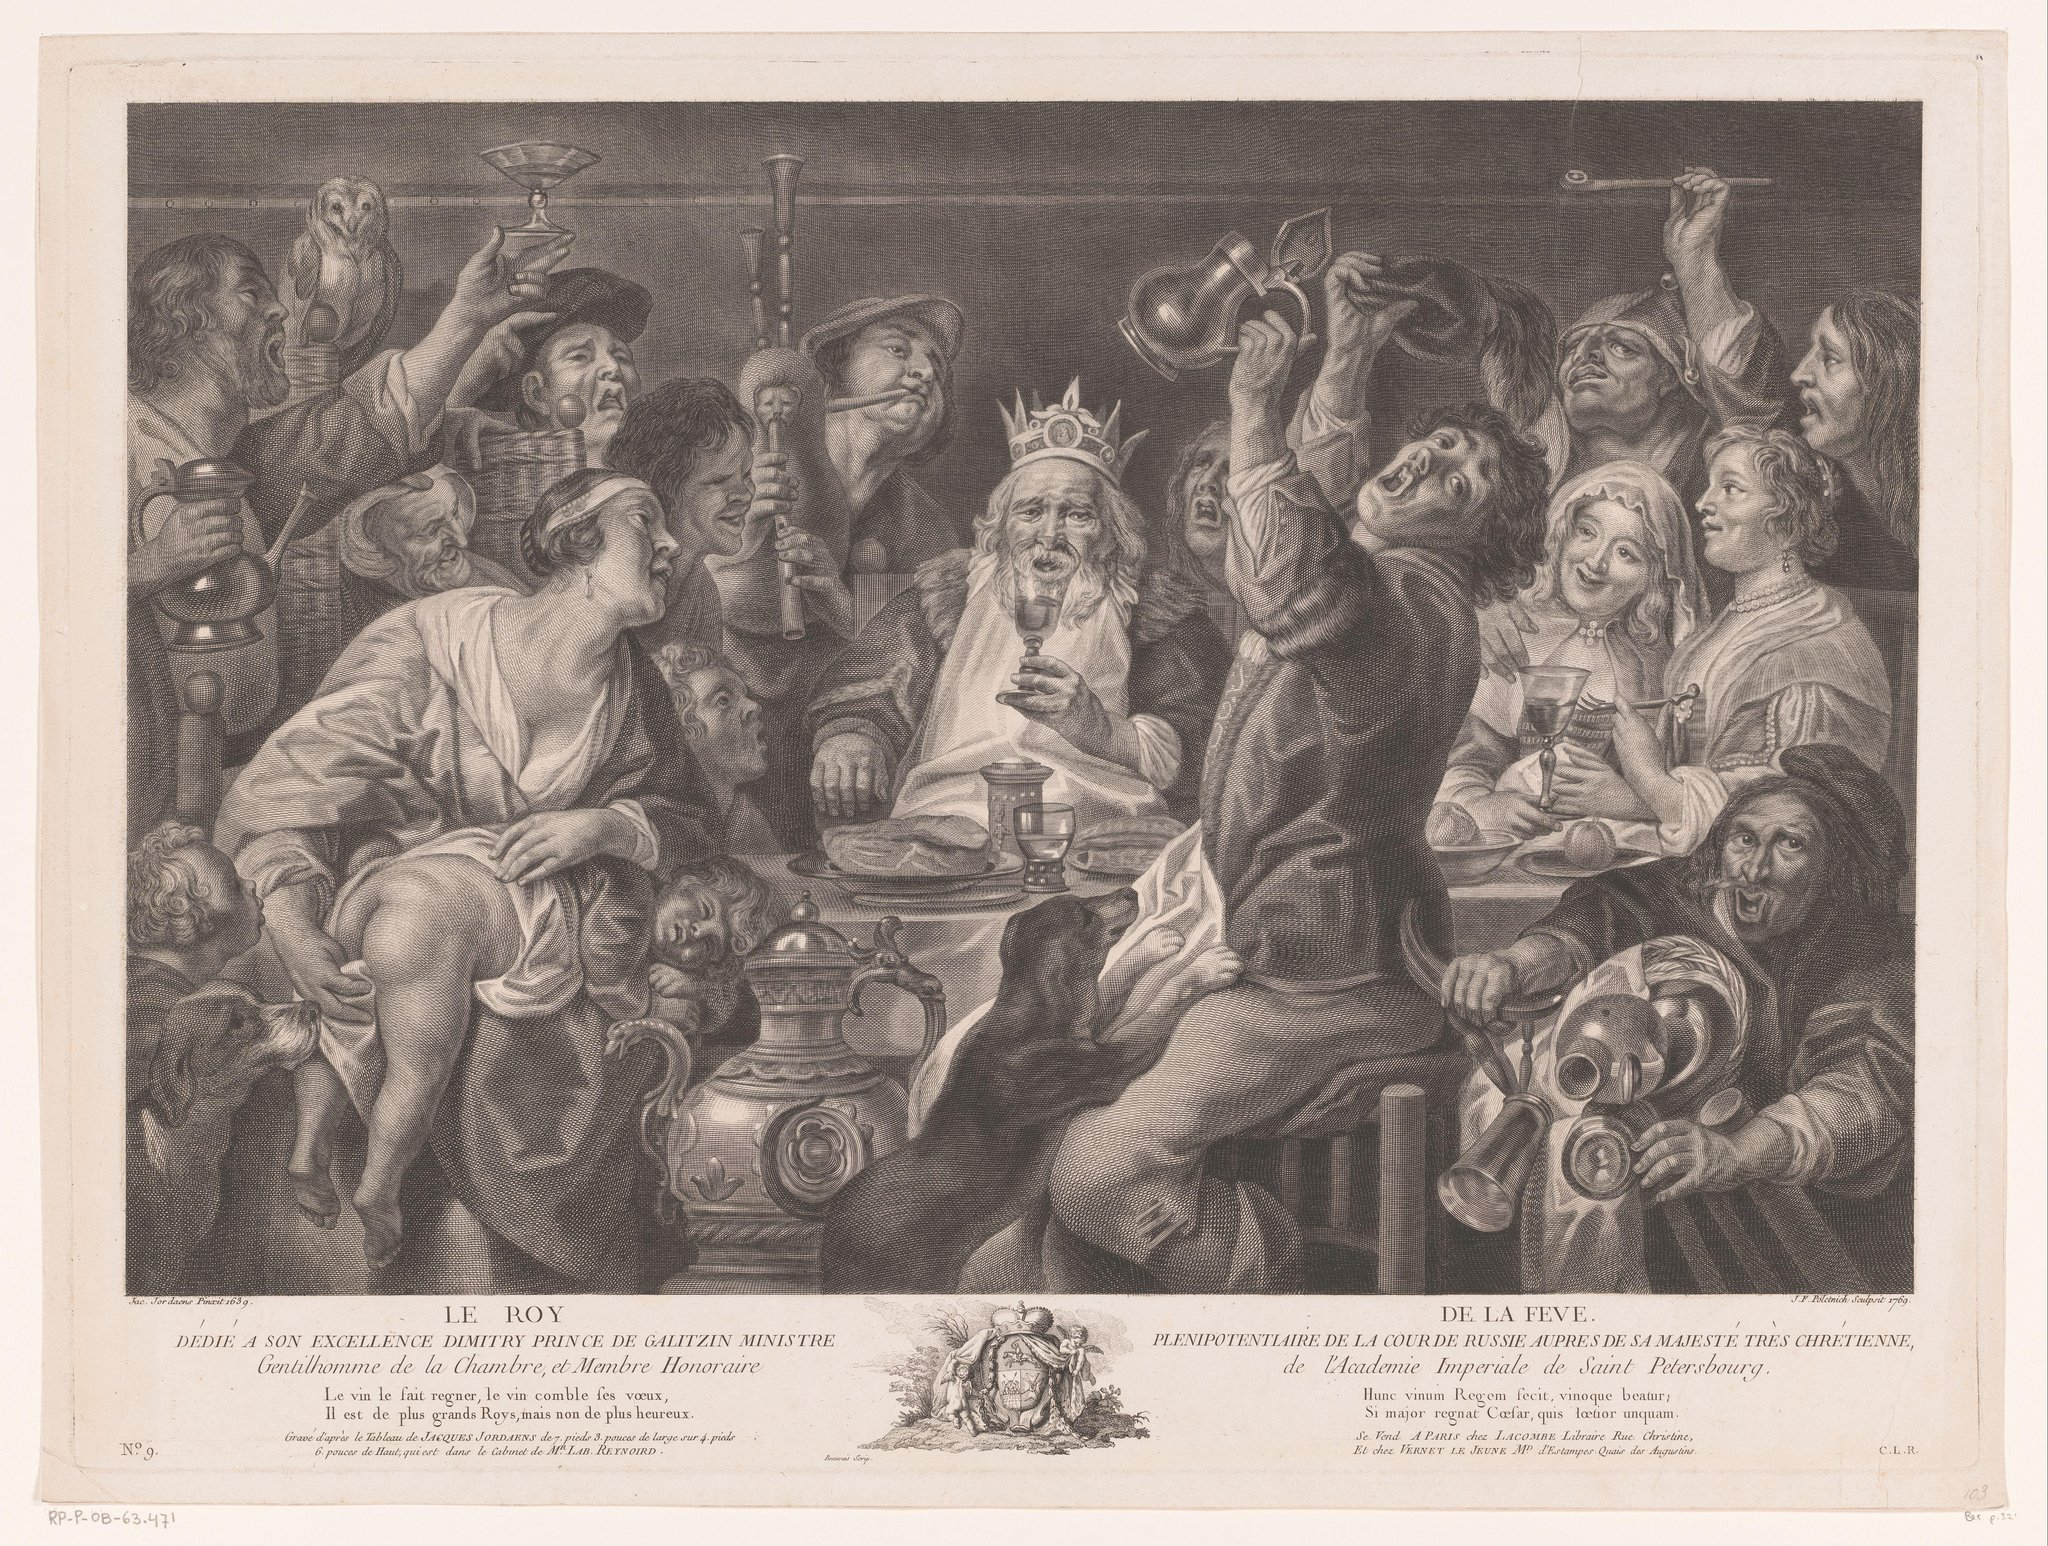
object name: print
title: Le Roy de la Feve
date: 1769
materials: paper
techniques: engraving, etching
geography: paris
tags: twelfth night, usually falling on the eve of january 6, drunkenness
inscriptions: collector's mark: Lugt 240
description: Feestmaal met in het midden een man met koningskroon op het hoofd, het glas heffend. Linksonder genummerd: 9.